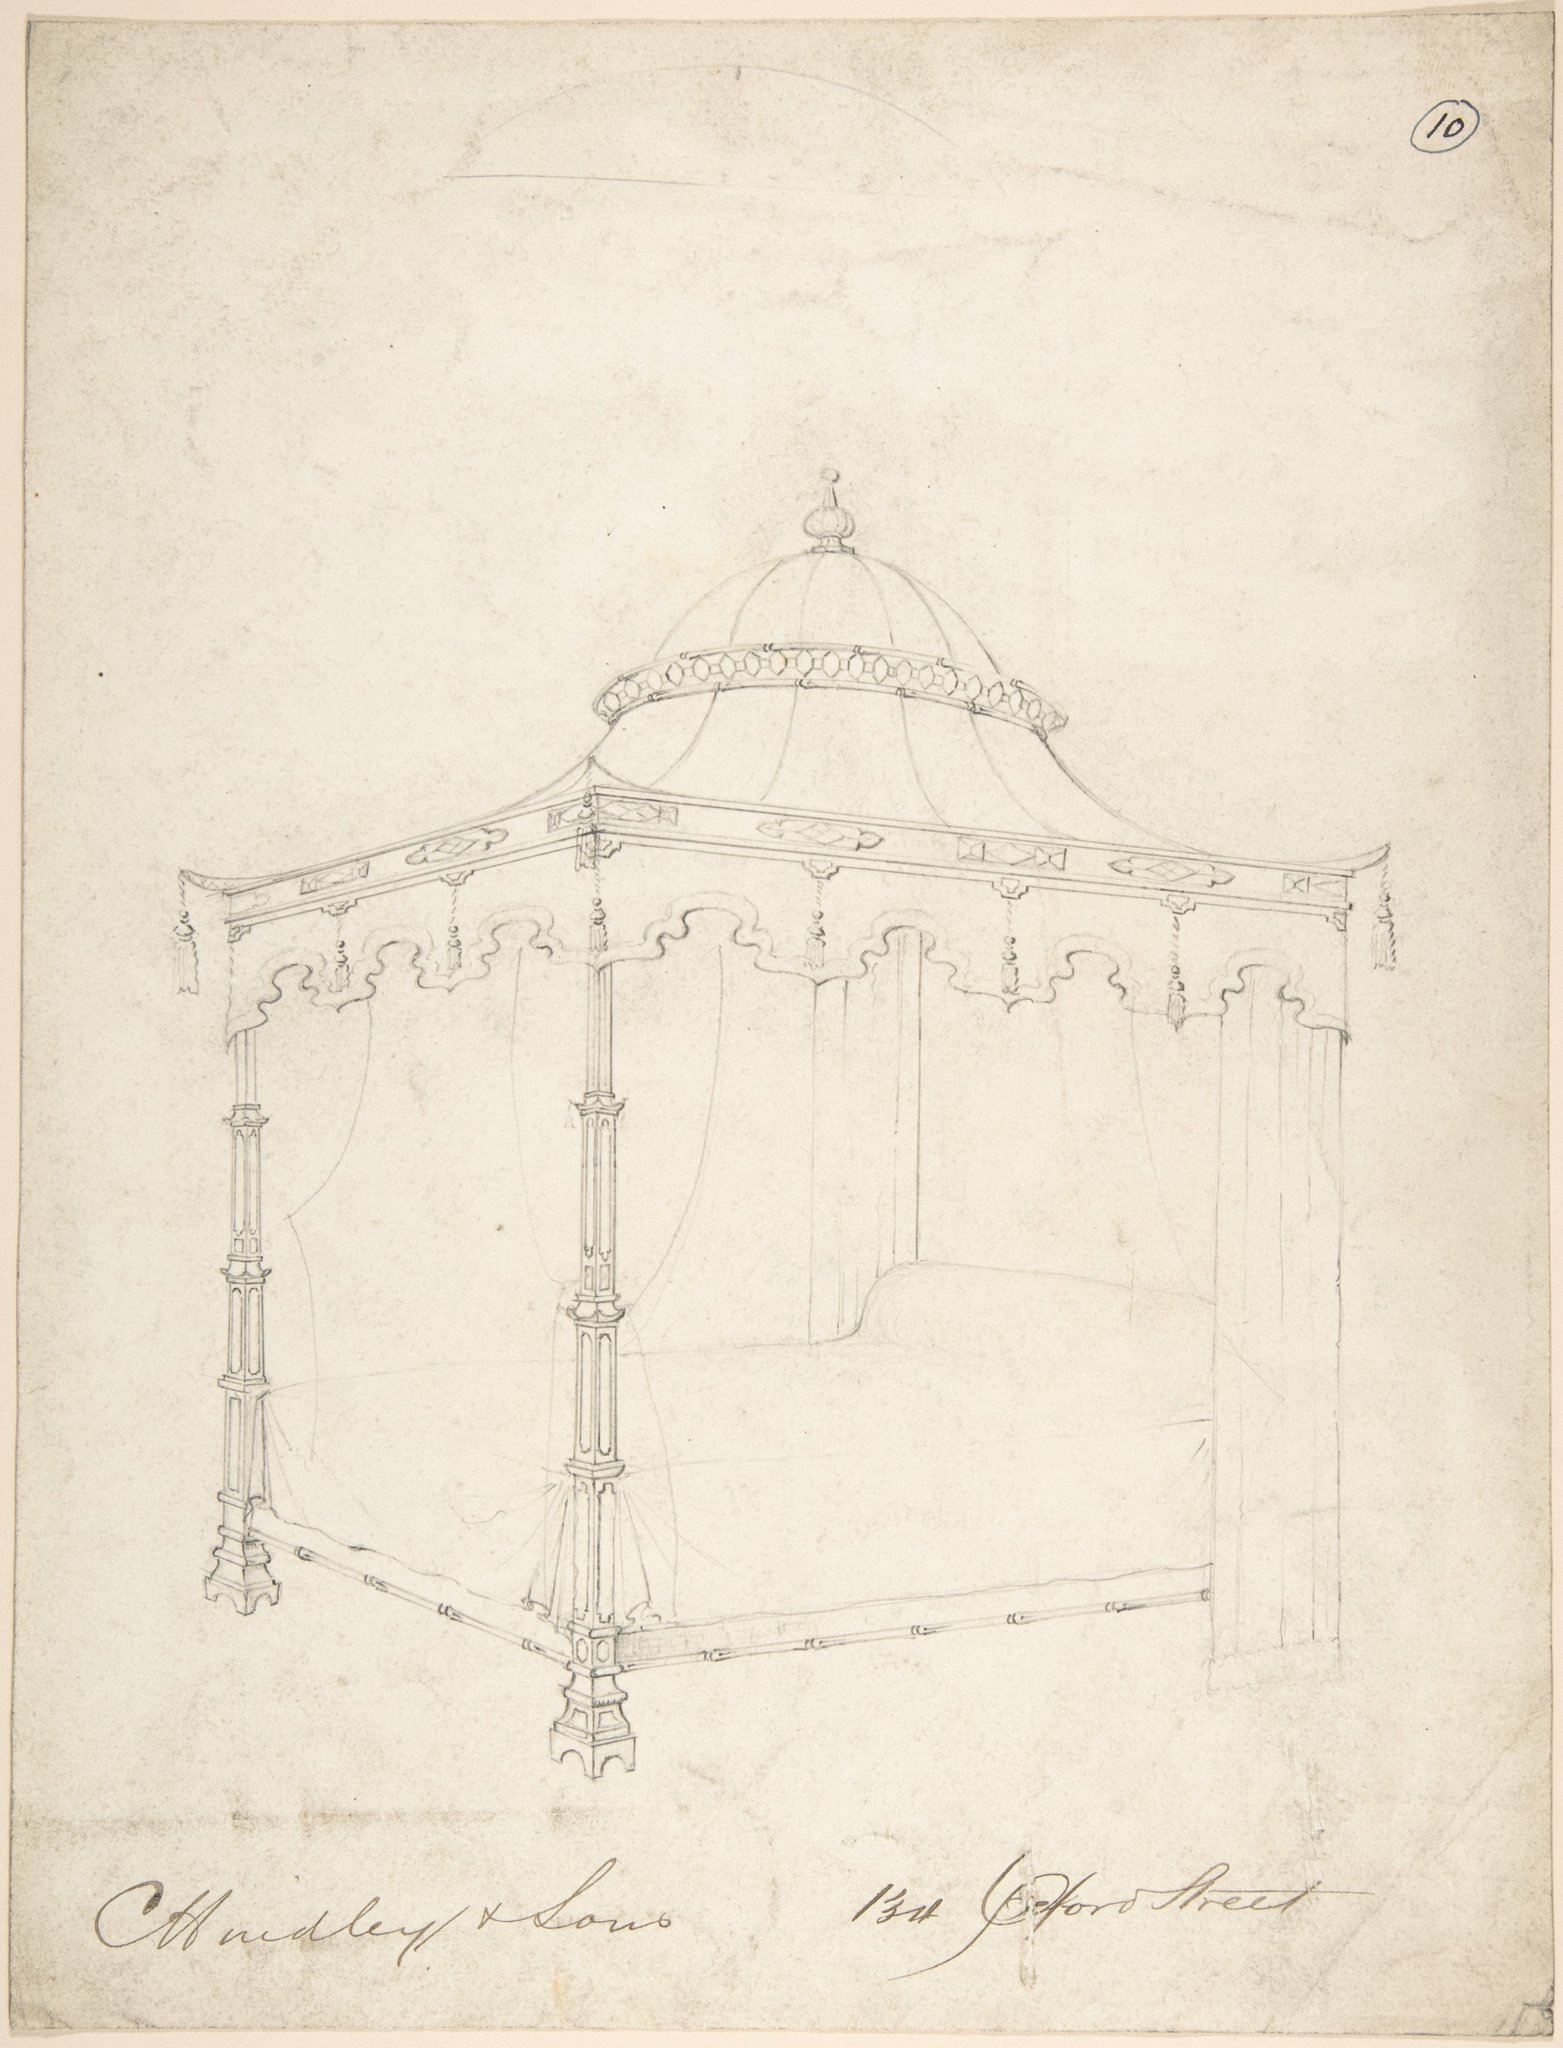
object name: drawing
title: Design for Bed and Canopy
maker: charles hindley and sons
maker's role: artist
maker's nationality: british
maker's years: 1841-1917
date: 1841-1884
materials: graphite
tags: beds